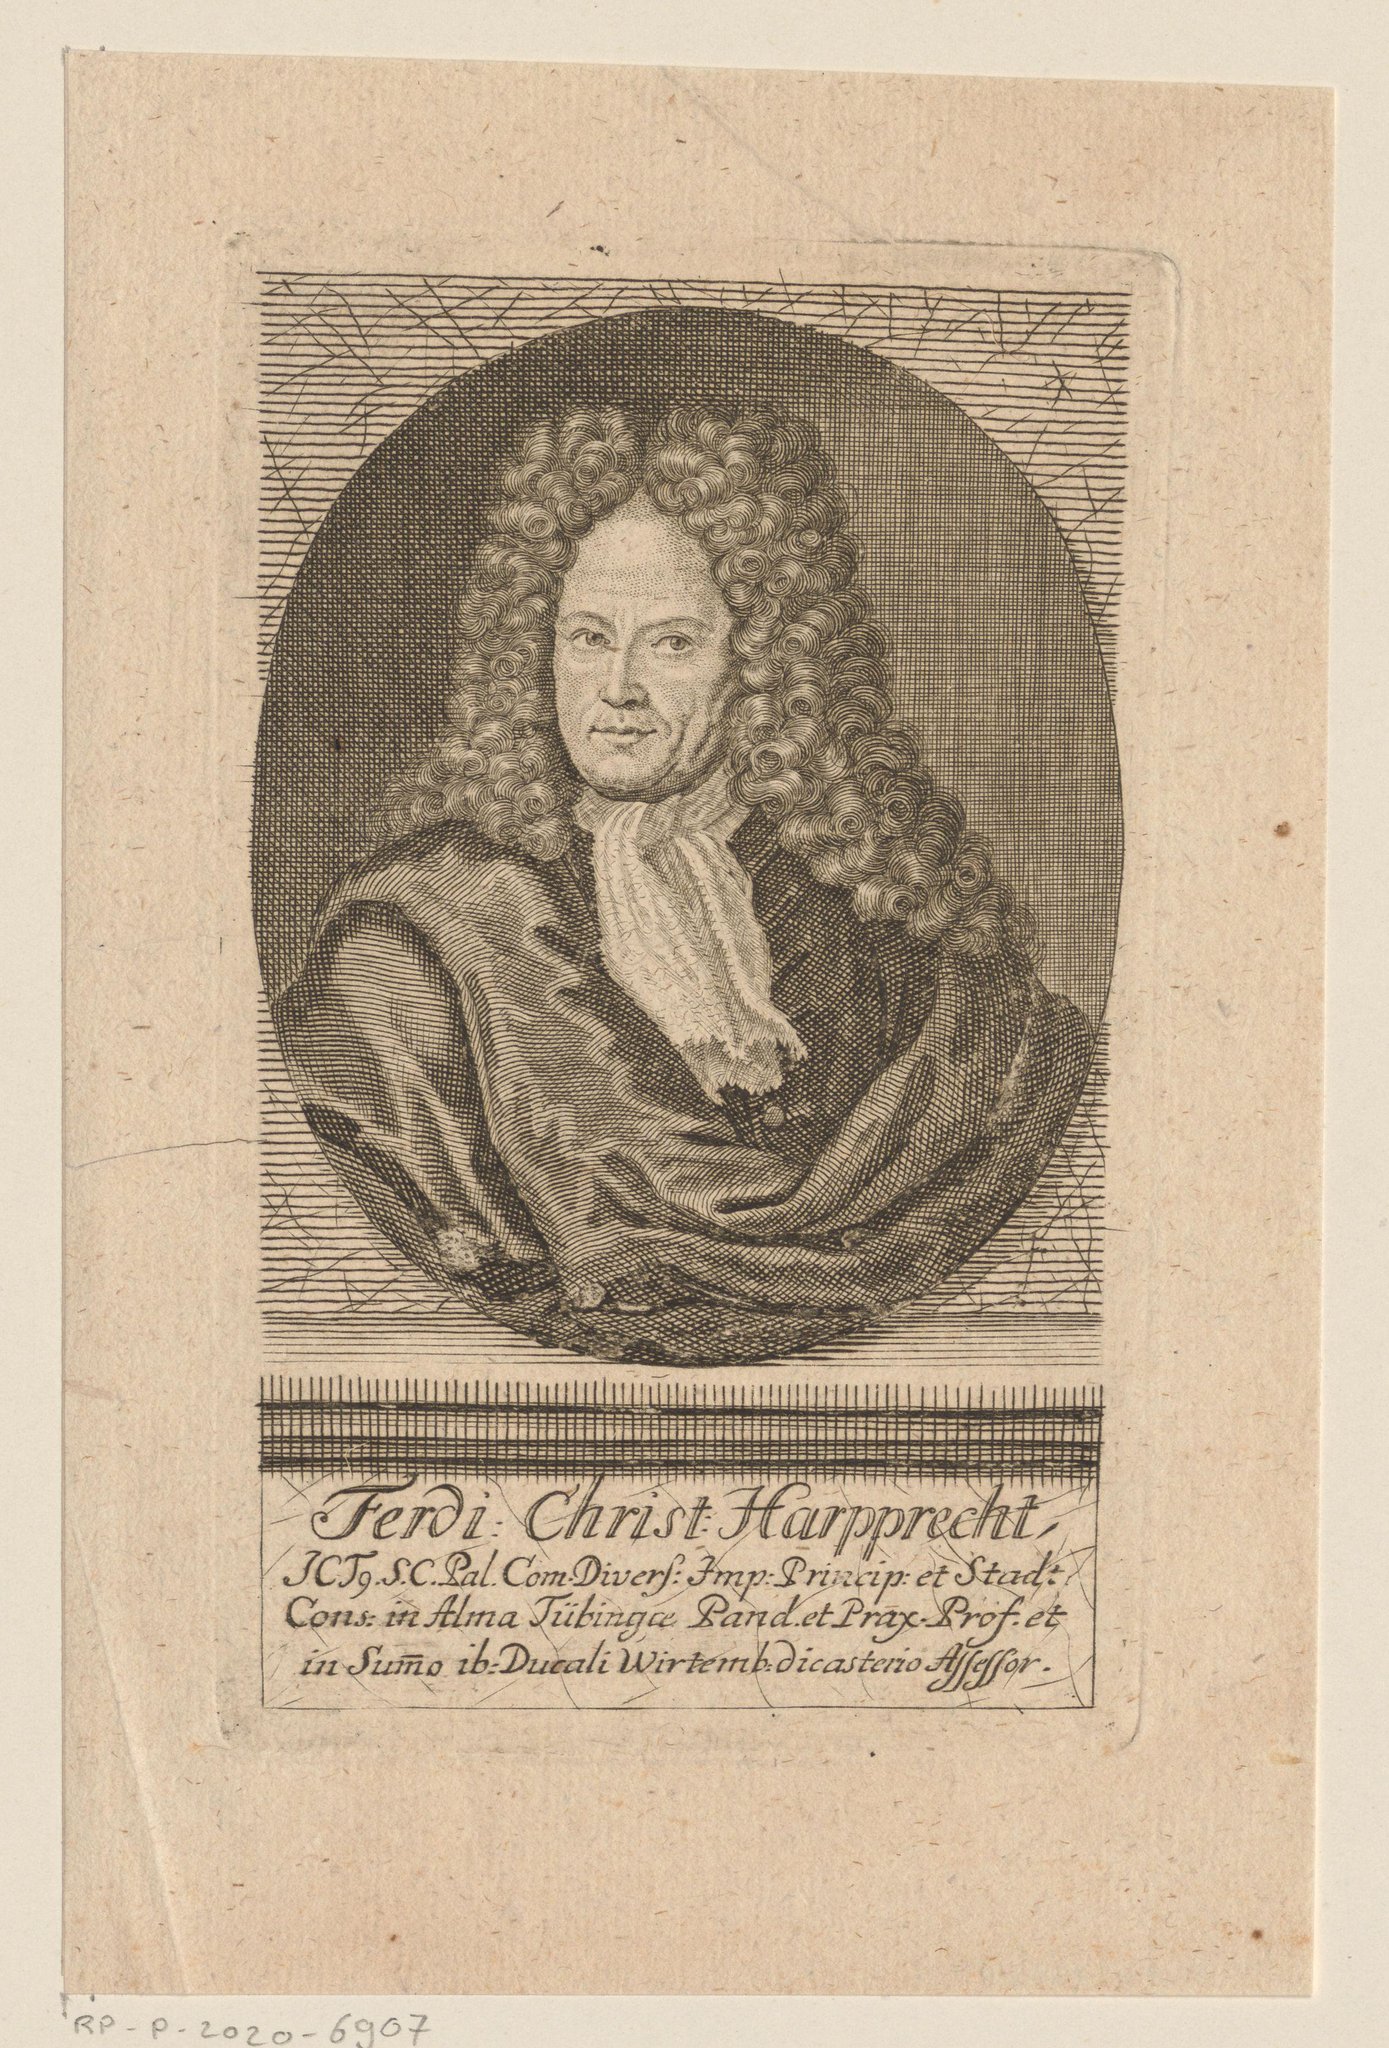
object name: print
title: Portret van Ferdinand Christoph Harpprecht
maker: Anonymous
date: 1678-1724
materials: paper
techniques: engraving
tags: historical persons, professor